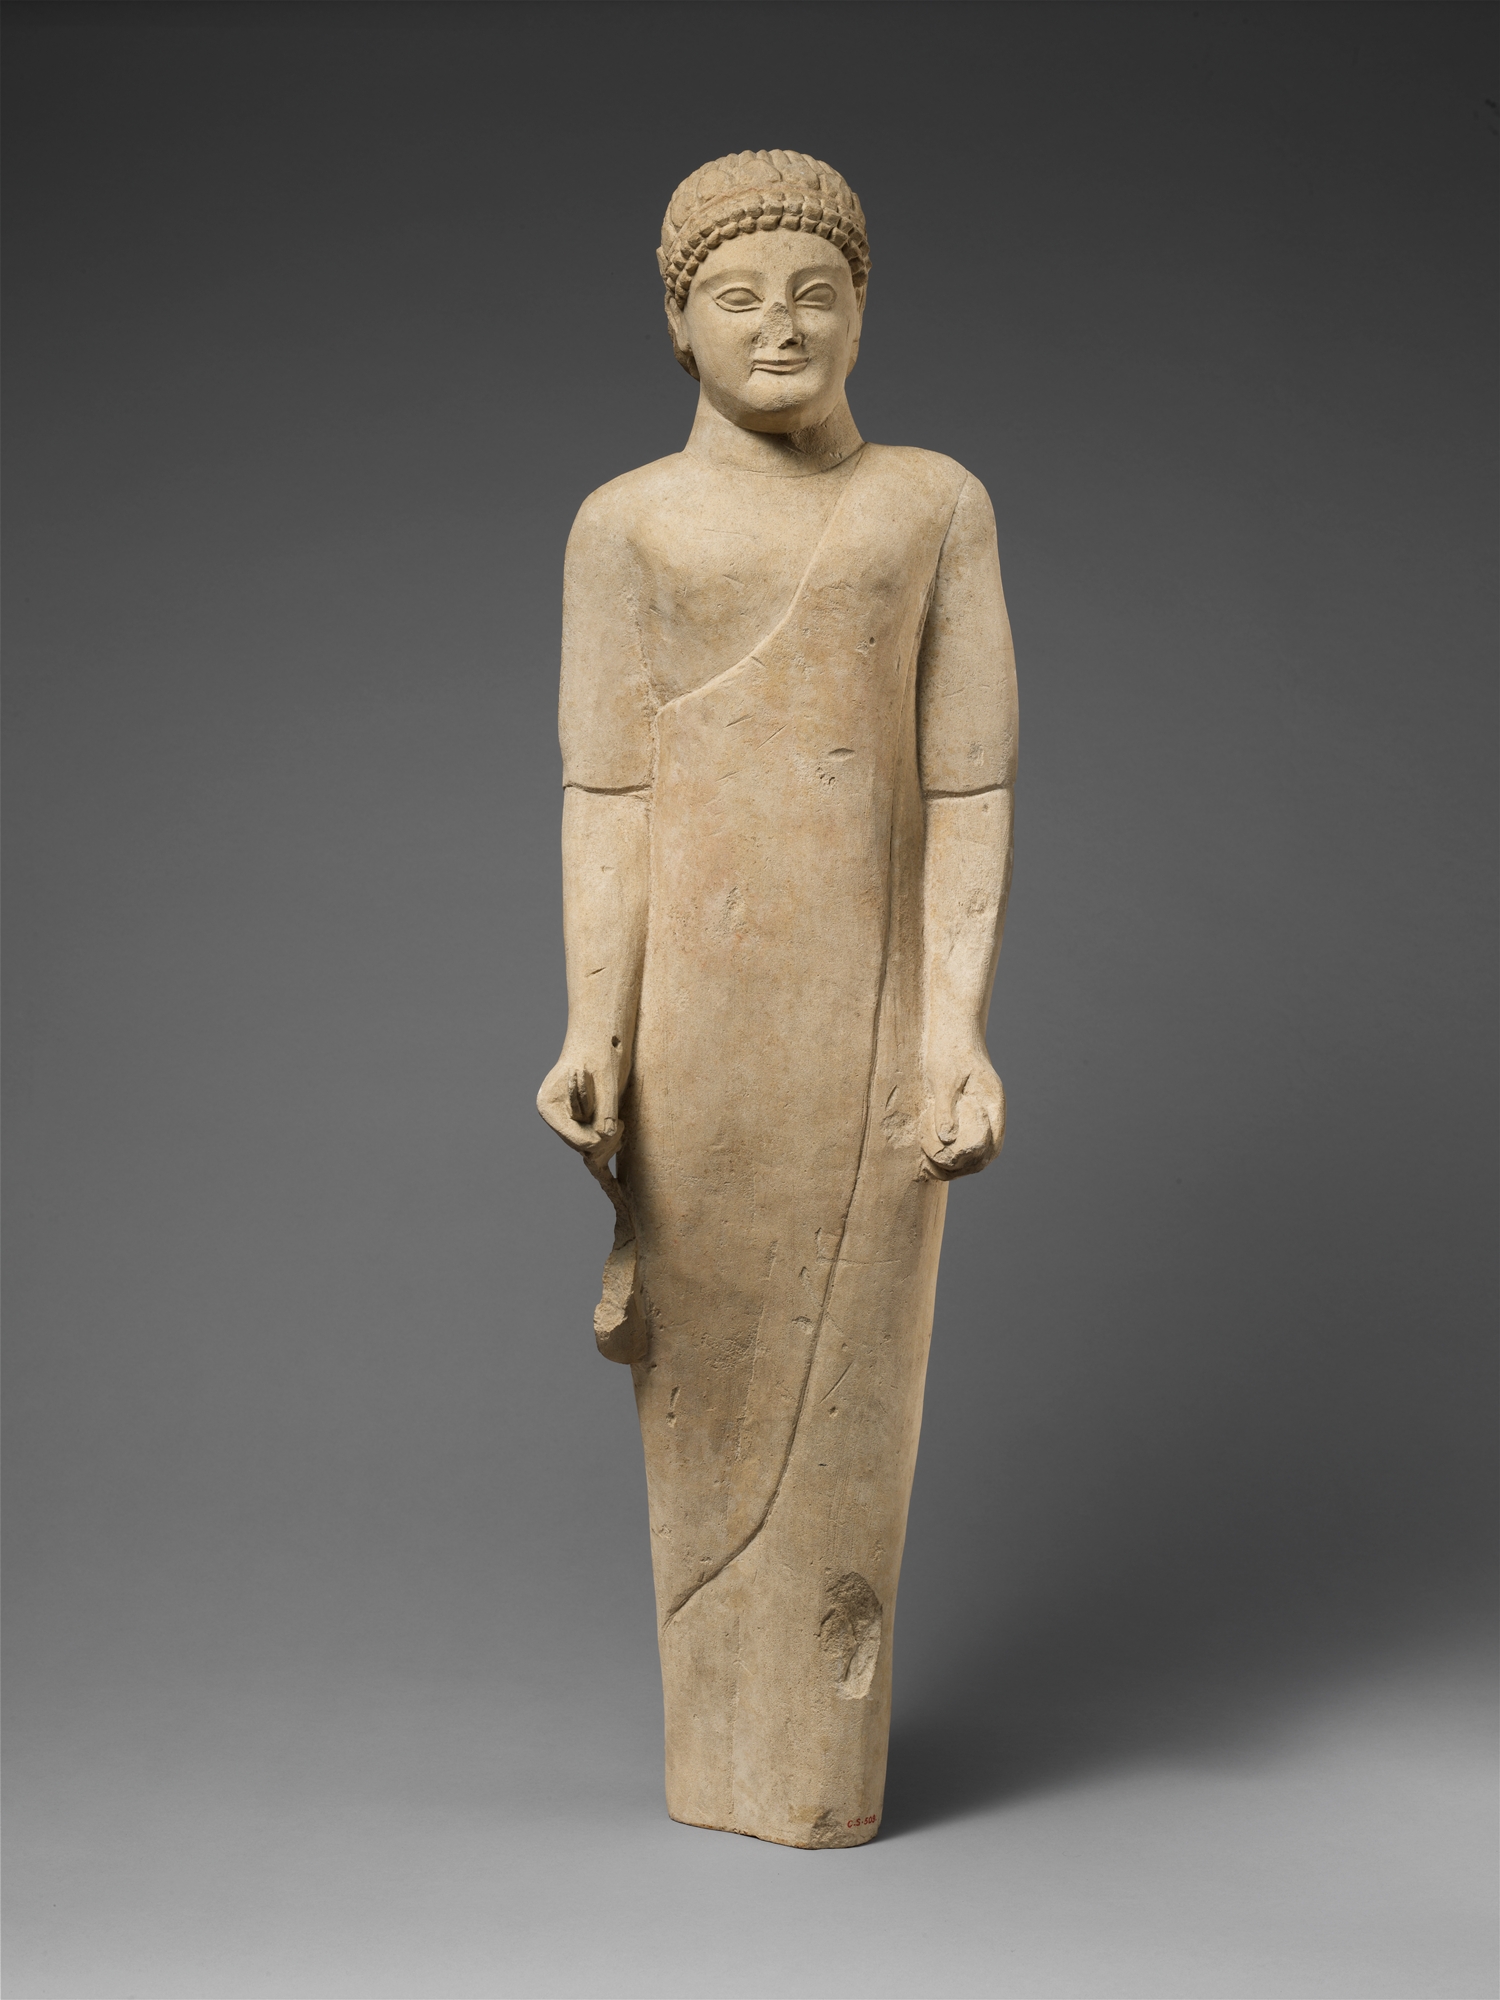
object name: statue of a votary, male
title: Limestone statuette of a beardless male votary with a wreath of leaves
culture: cypriot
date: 600-401 BCE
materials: limestone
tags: men,wreaths